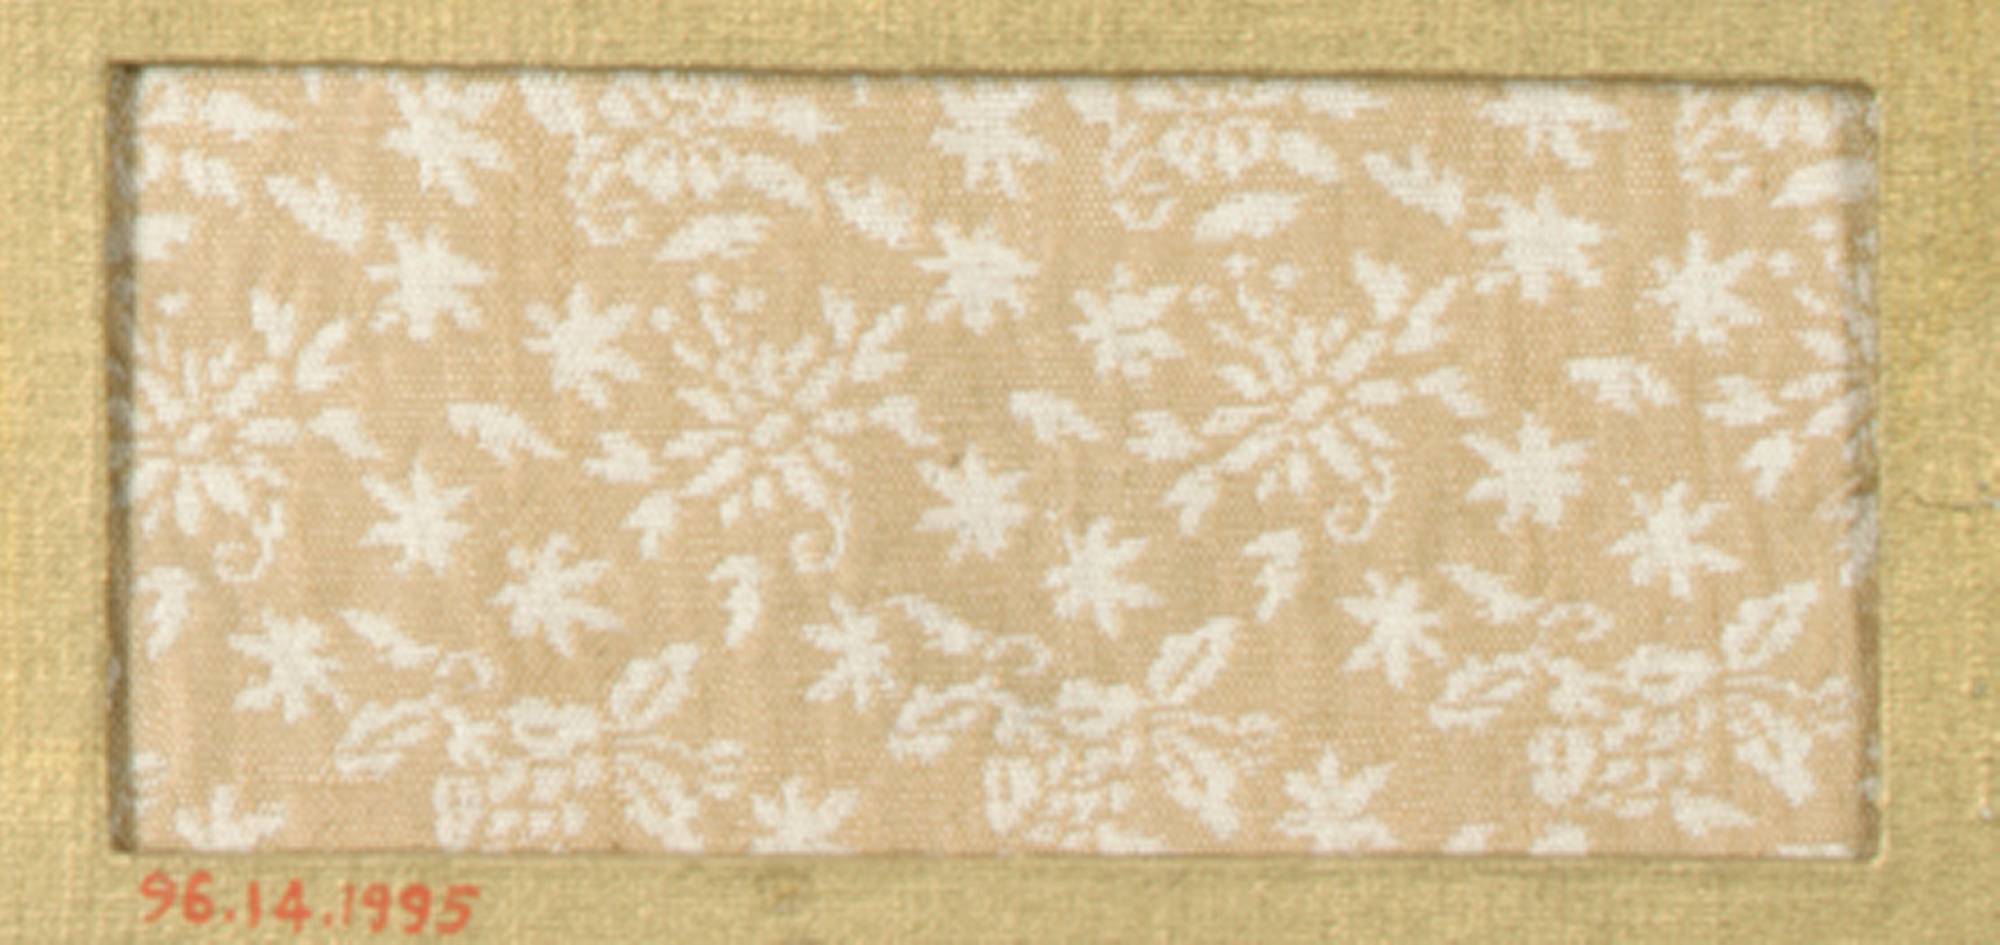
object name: piece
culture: japanese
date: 1701-1900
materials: silk